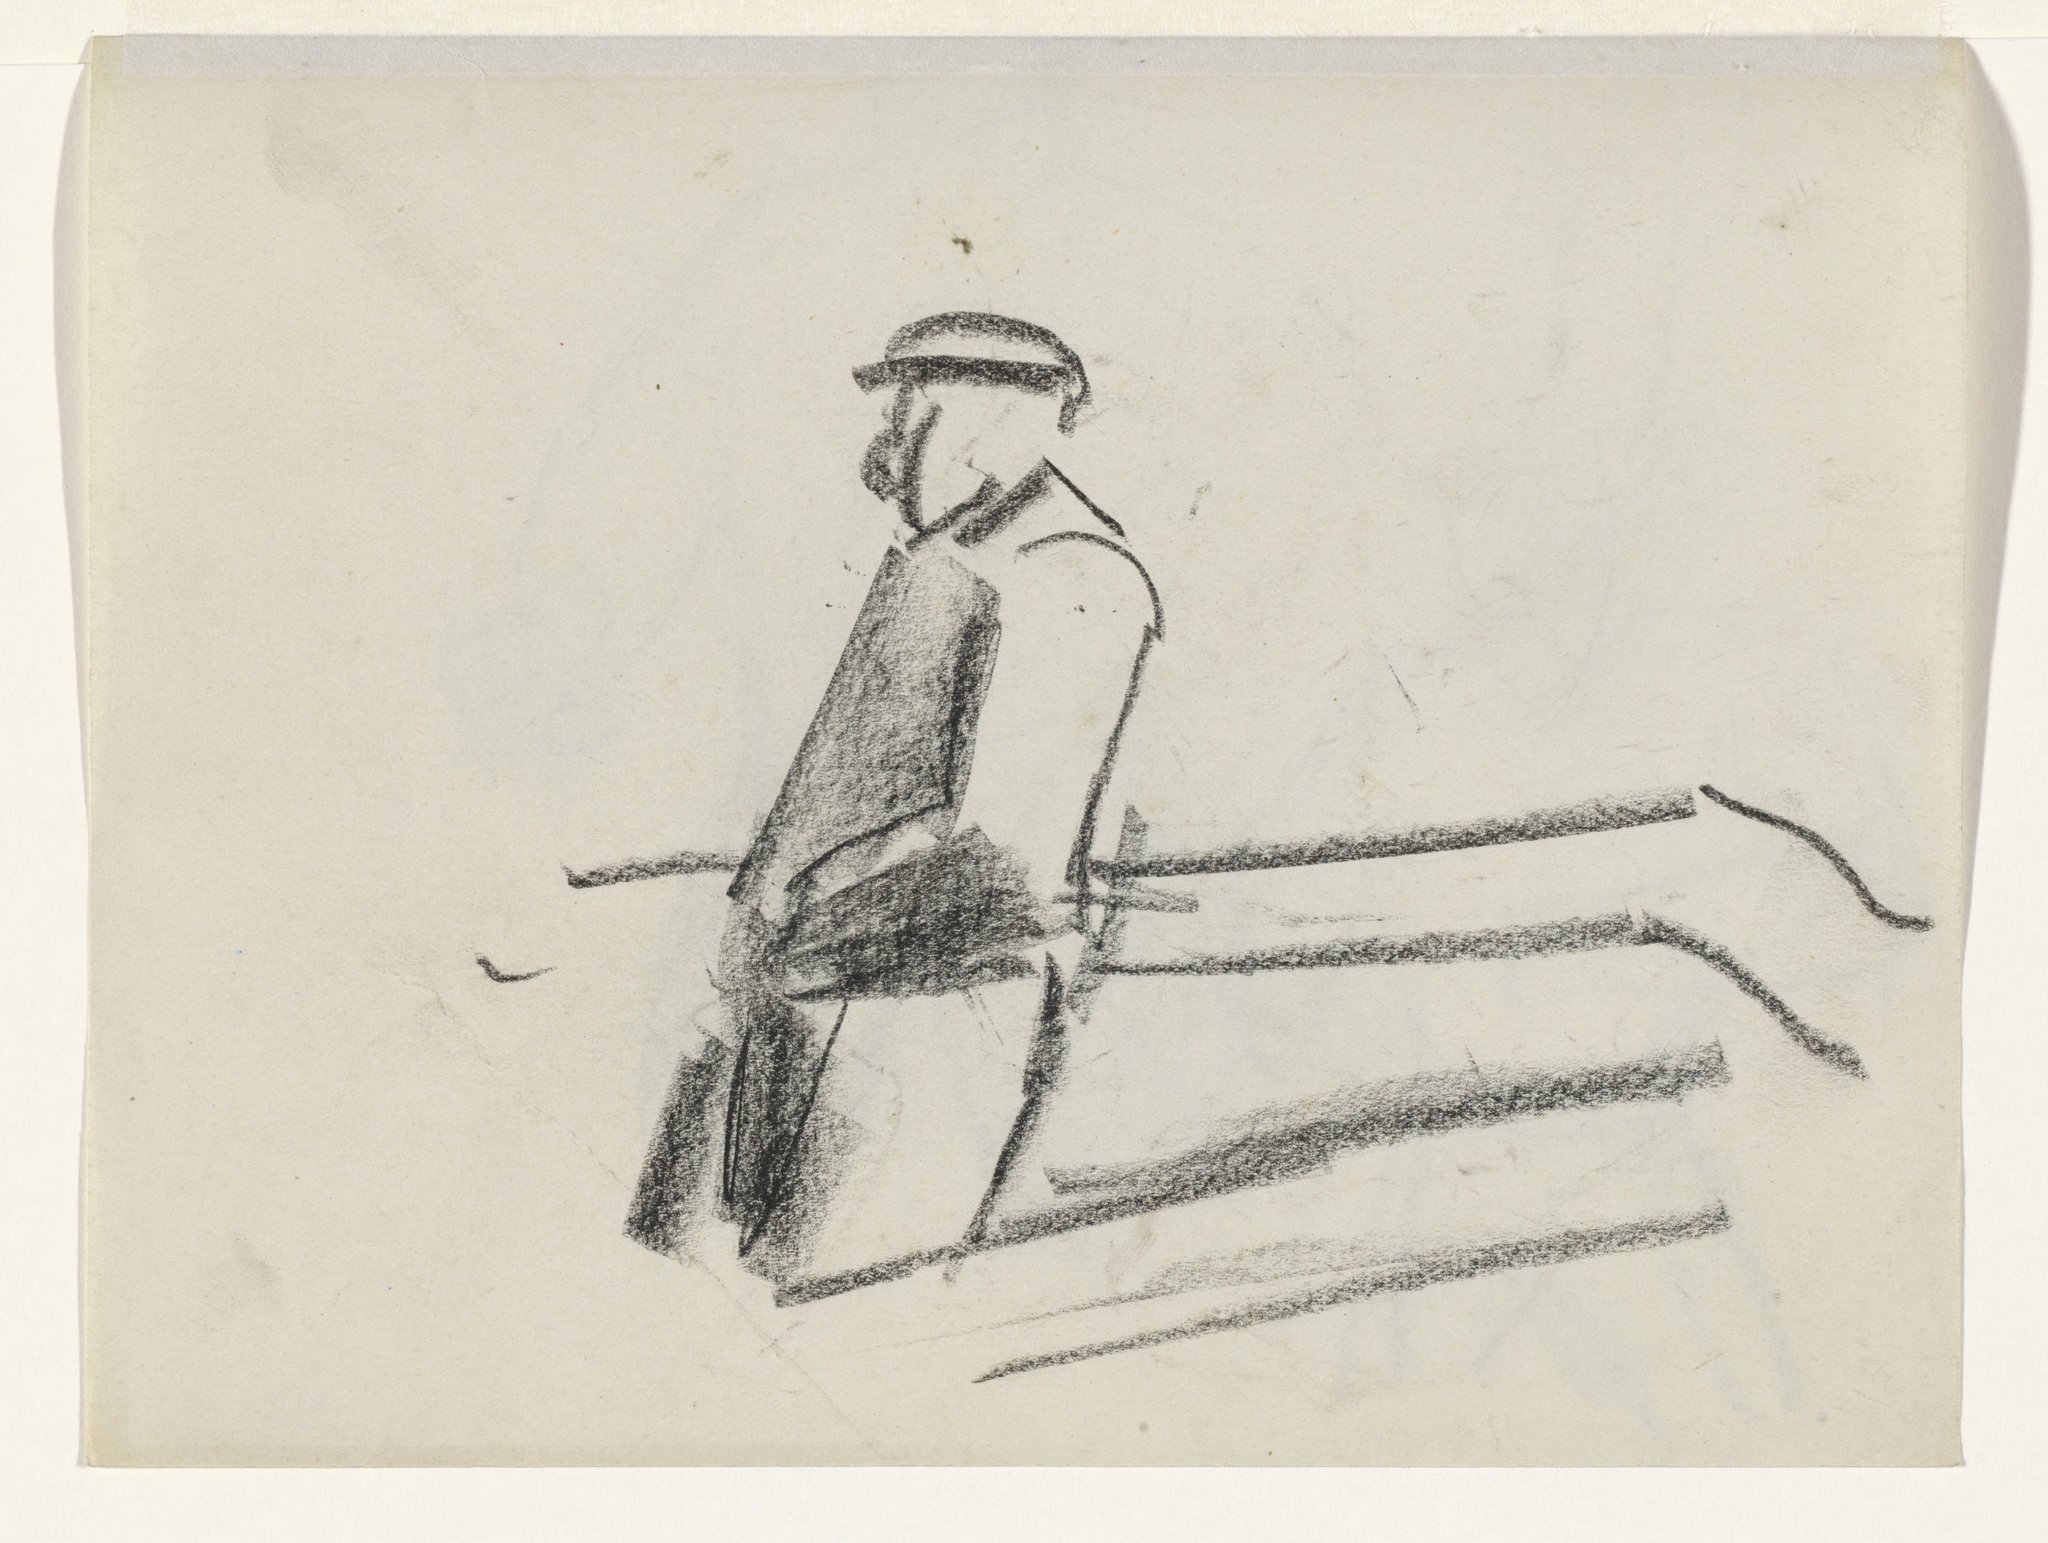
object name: drawing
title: Staande man op een boot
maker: leo gestel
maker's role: draughtsman, print maker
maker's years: 1881-1941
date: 1891-1941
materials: chalk, paper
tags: ships (in general), adult man (+ sideview, profile)